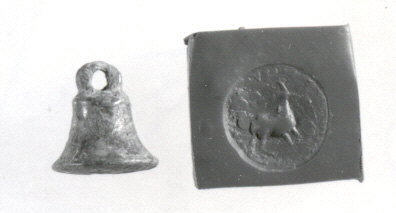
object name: stamp seal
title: Stamp seal (bell-shaped with loop handle) with animal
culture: urartian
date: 800-601 BCE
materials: alloy, bronze, copper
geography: urartu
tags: animals